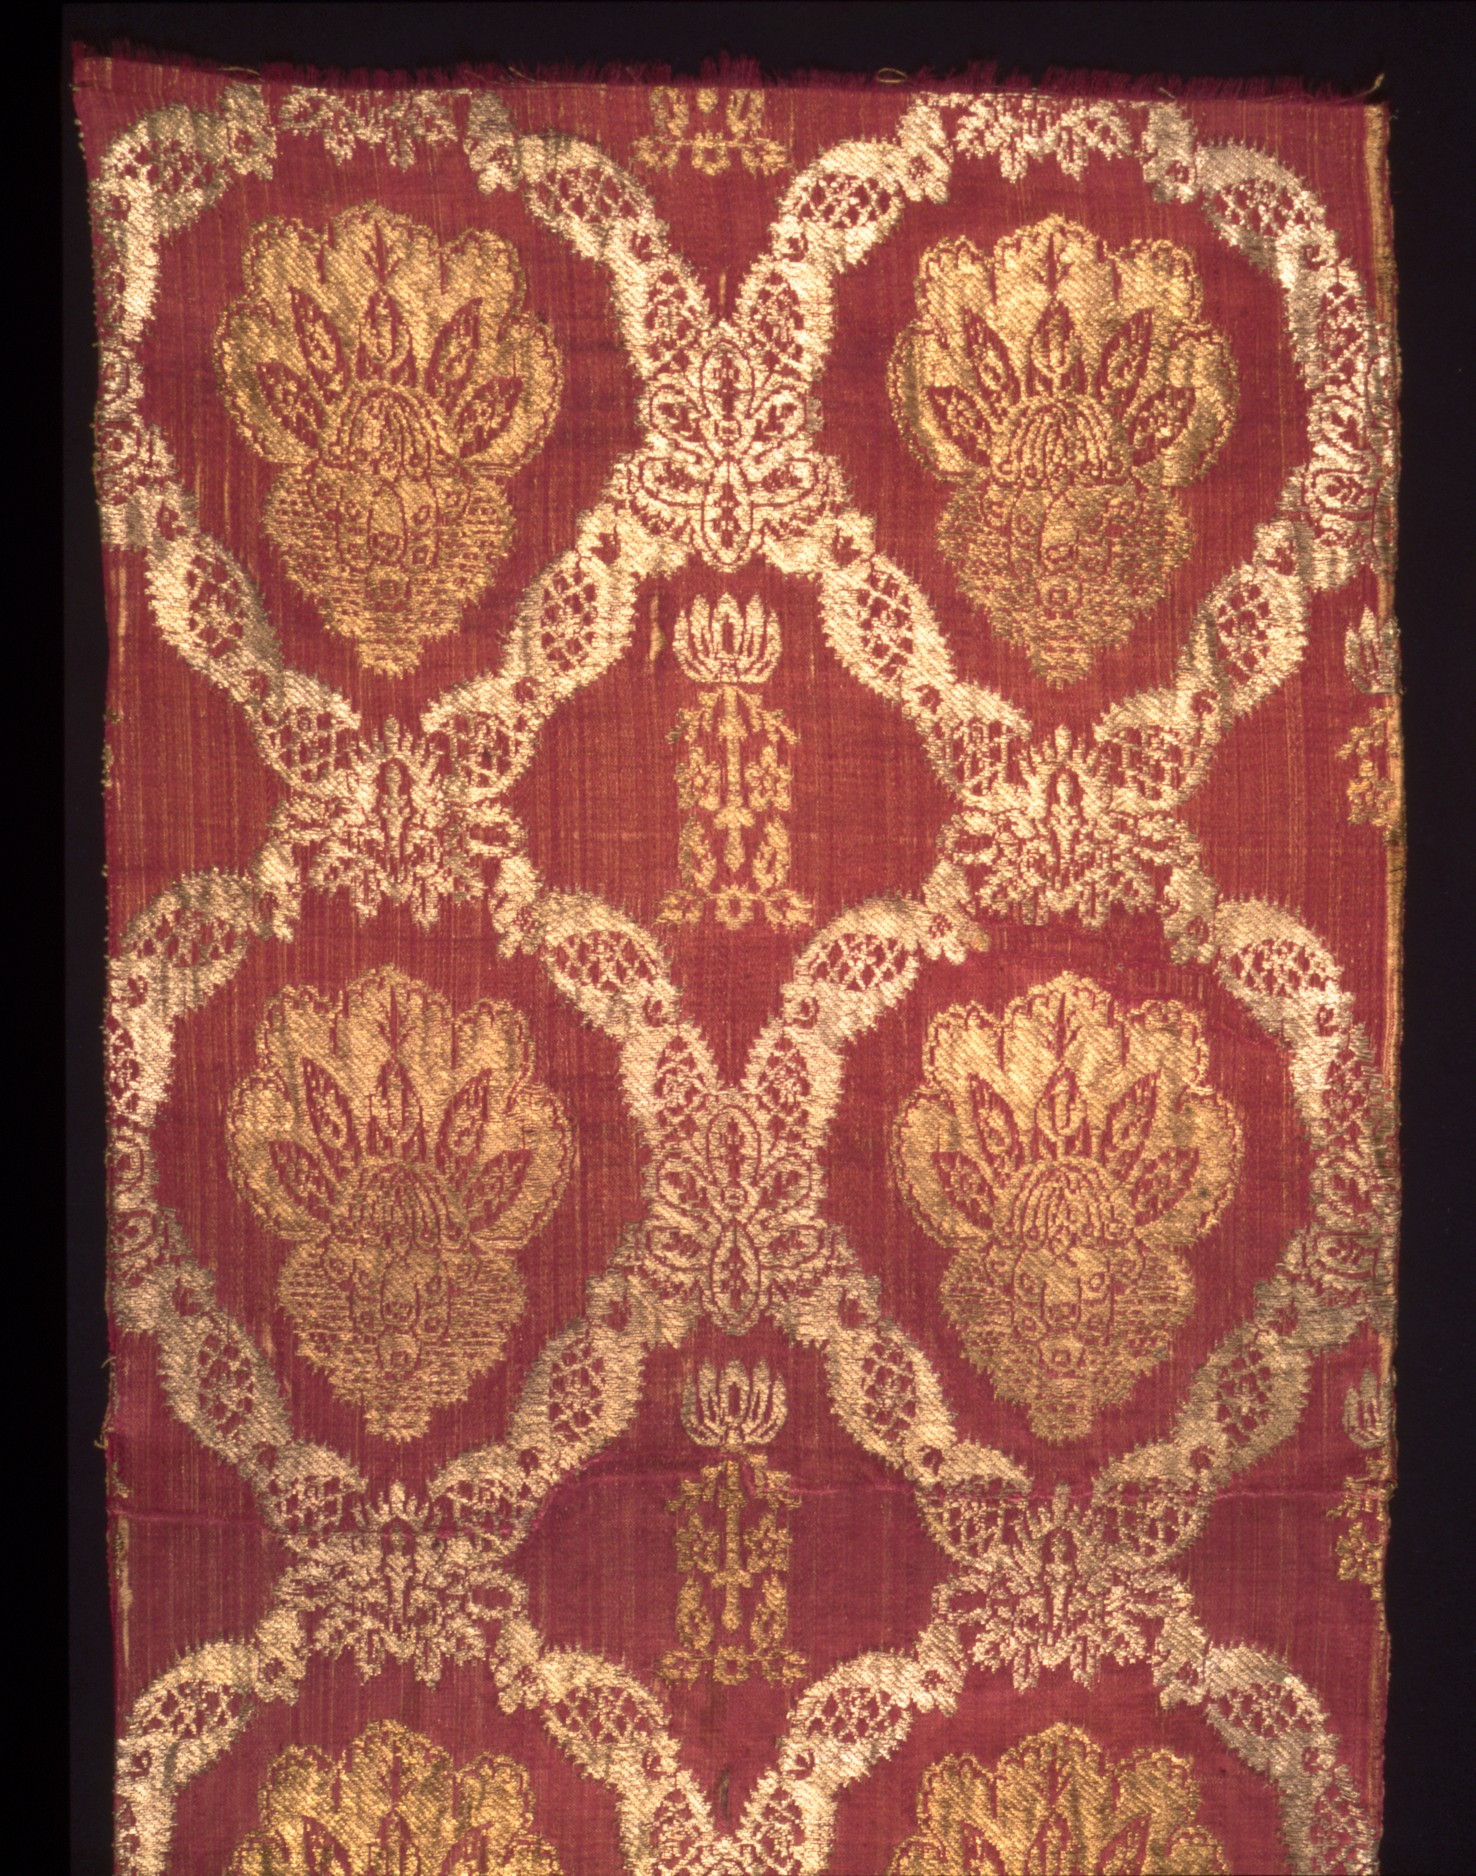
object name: textile panel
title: Panel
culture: french or italian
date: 1701-1733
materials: linen, metal, silk